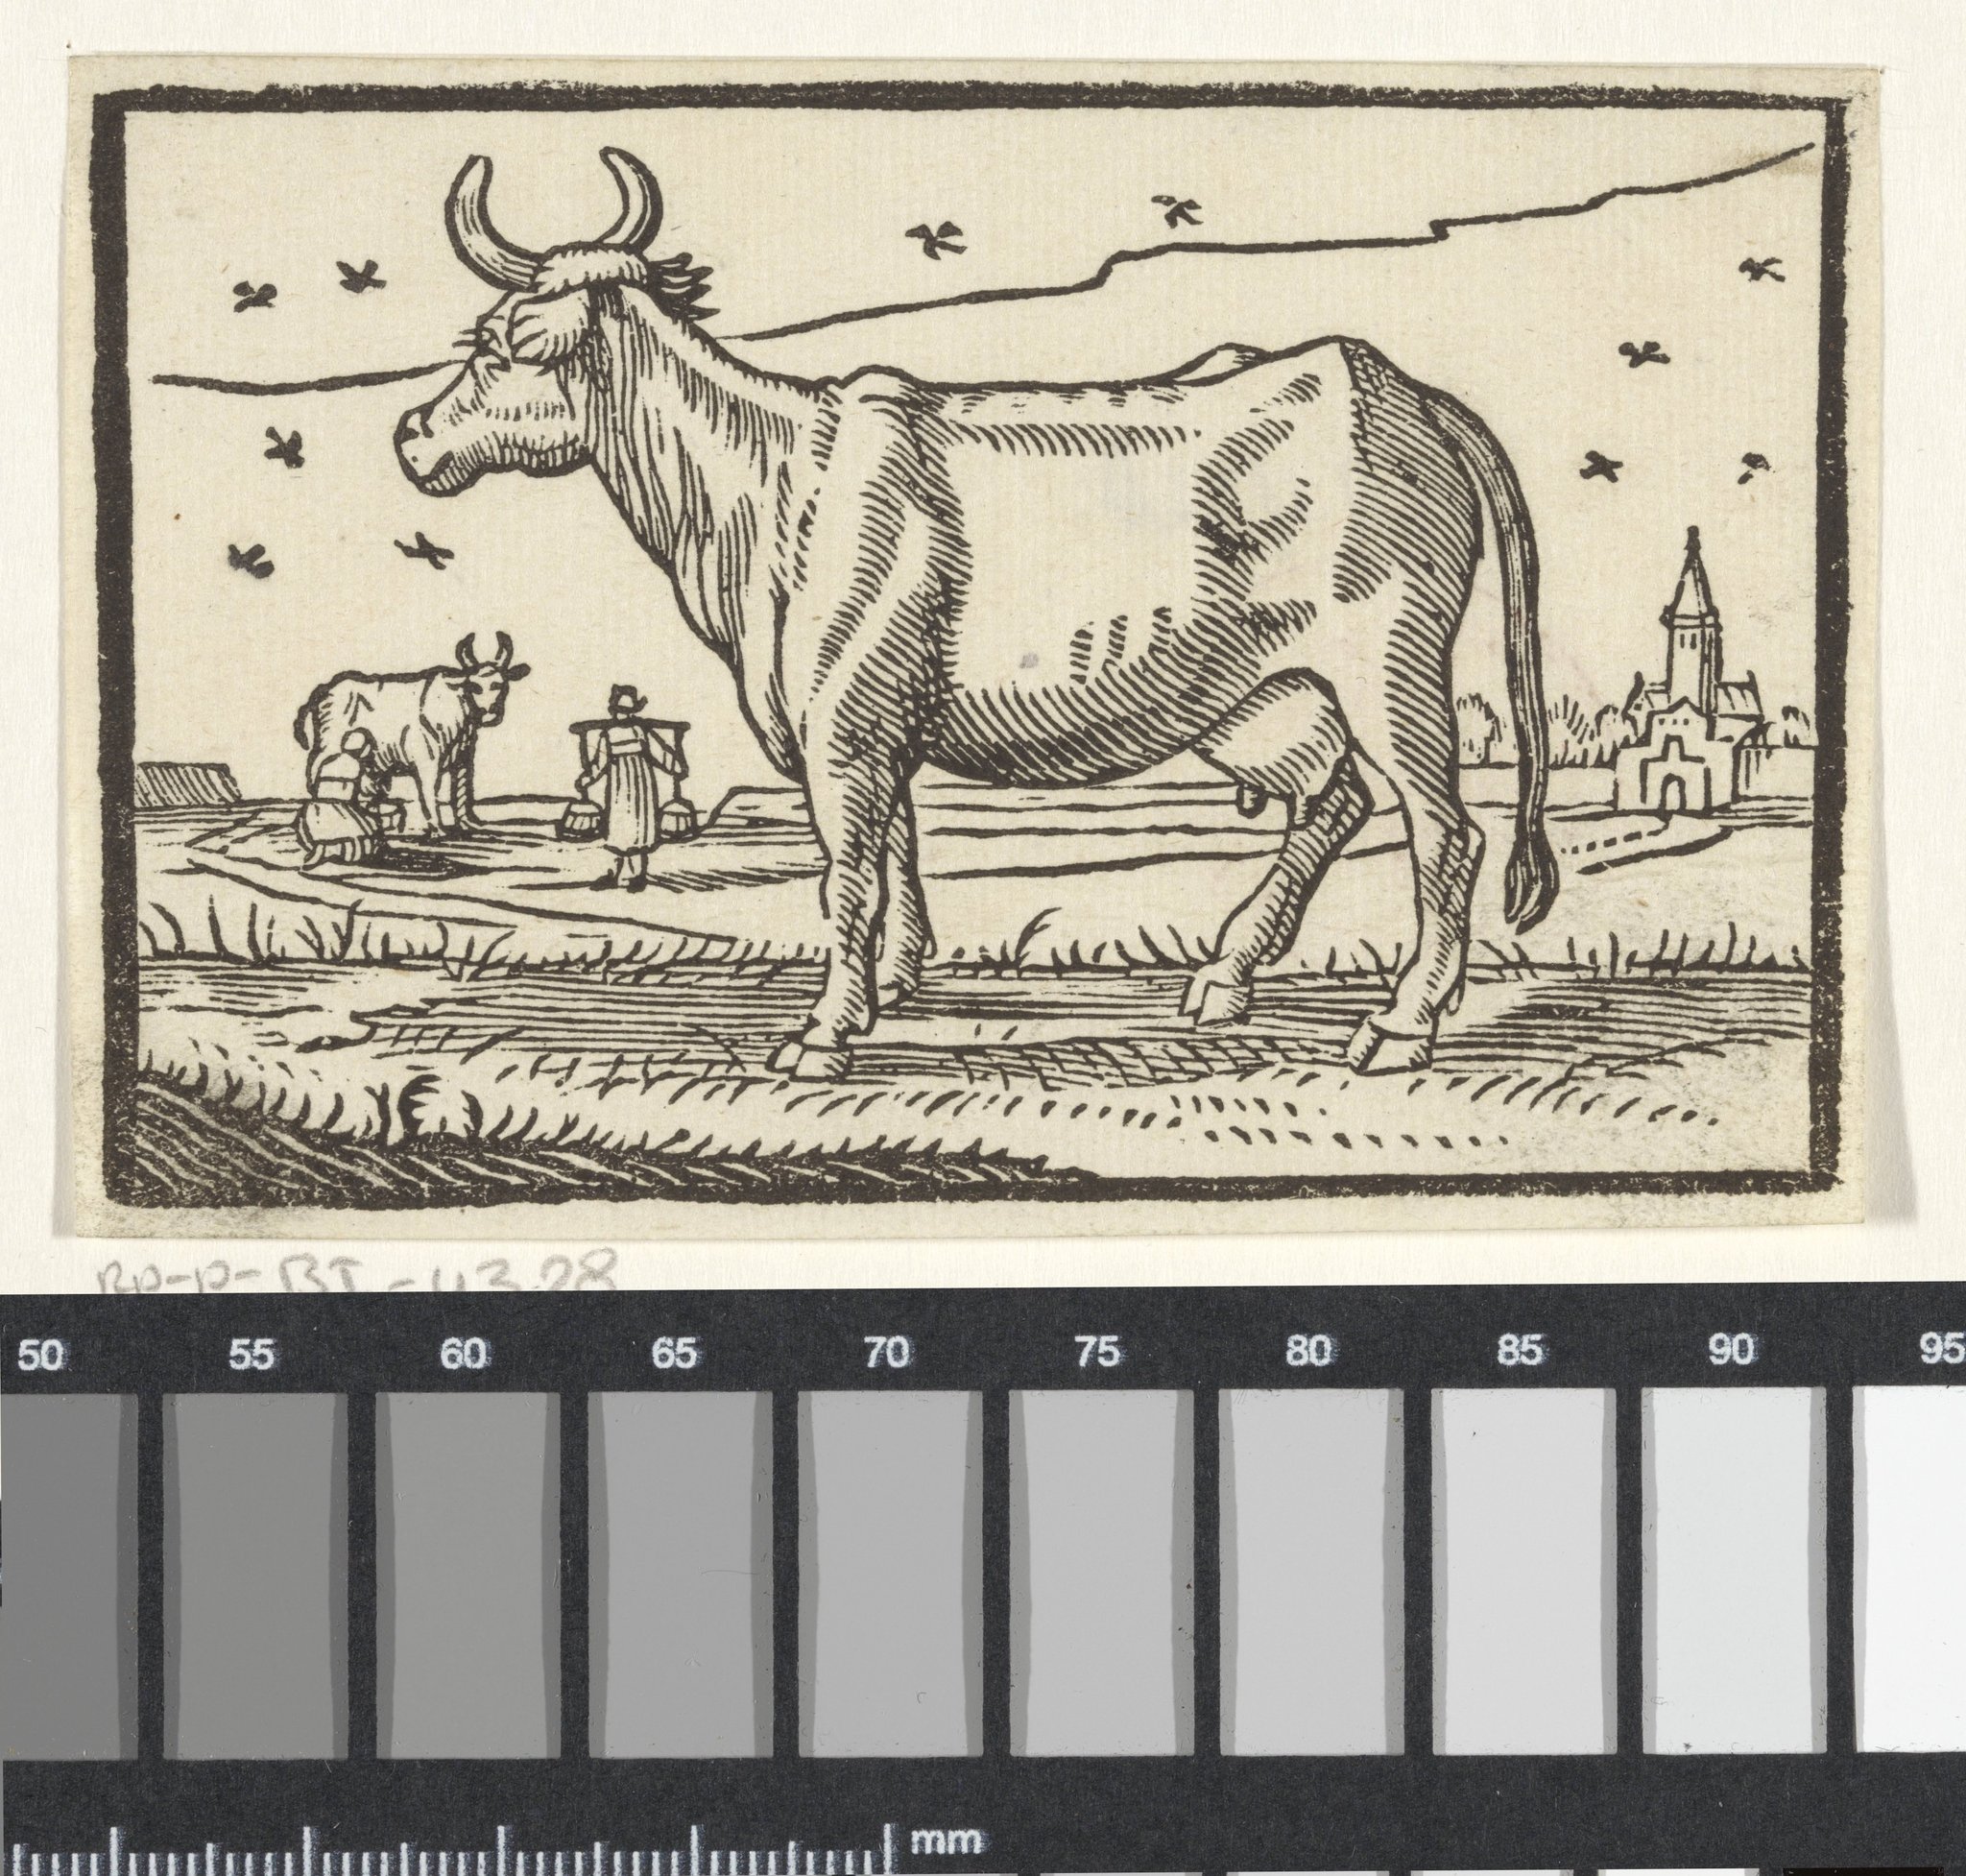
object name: print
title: Landschap met twee koeien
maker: Anonymous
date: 1600-1699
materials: paper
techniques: woodcut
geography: netherlands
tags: cow, milking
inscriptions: collector's mark: Lugt 240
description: Landschap met op de voorgrond een wei met twee koeien, waarvan er één gemolken wordt. Op de achtergrond een dorp met een kerktoren.